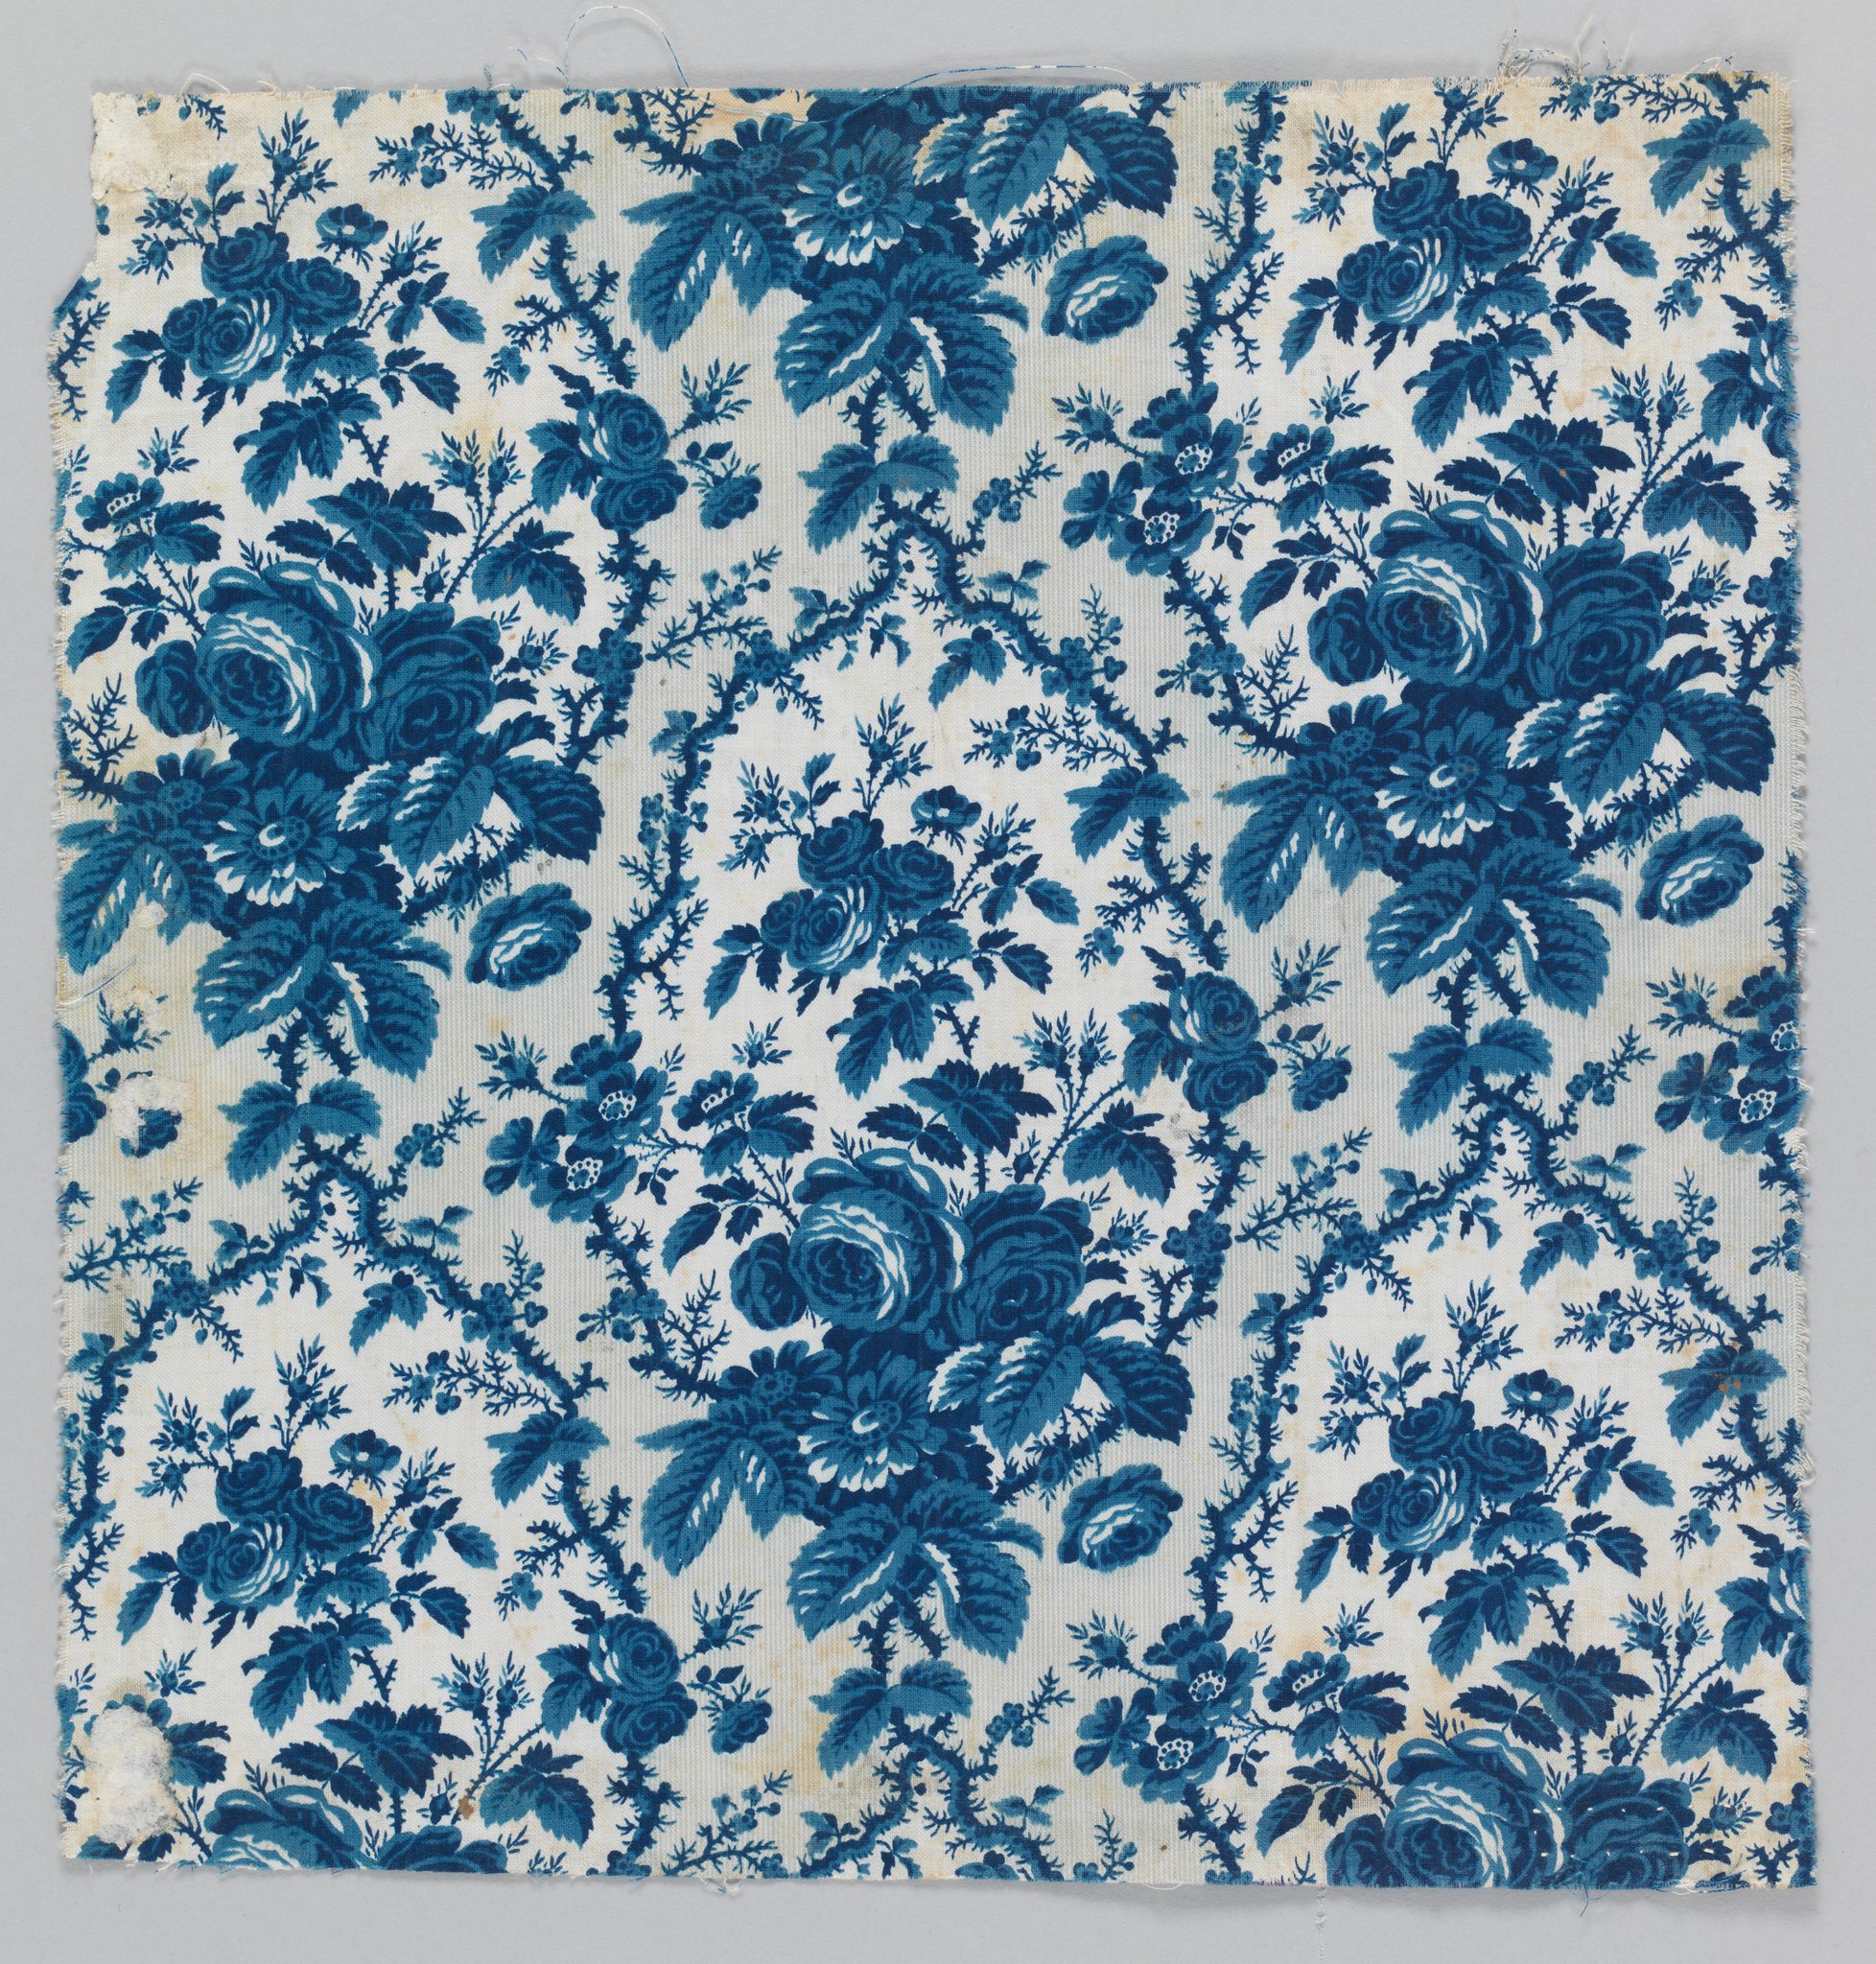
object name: piece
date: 1801-1900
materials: cotton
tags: flowers